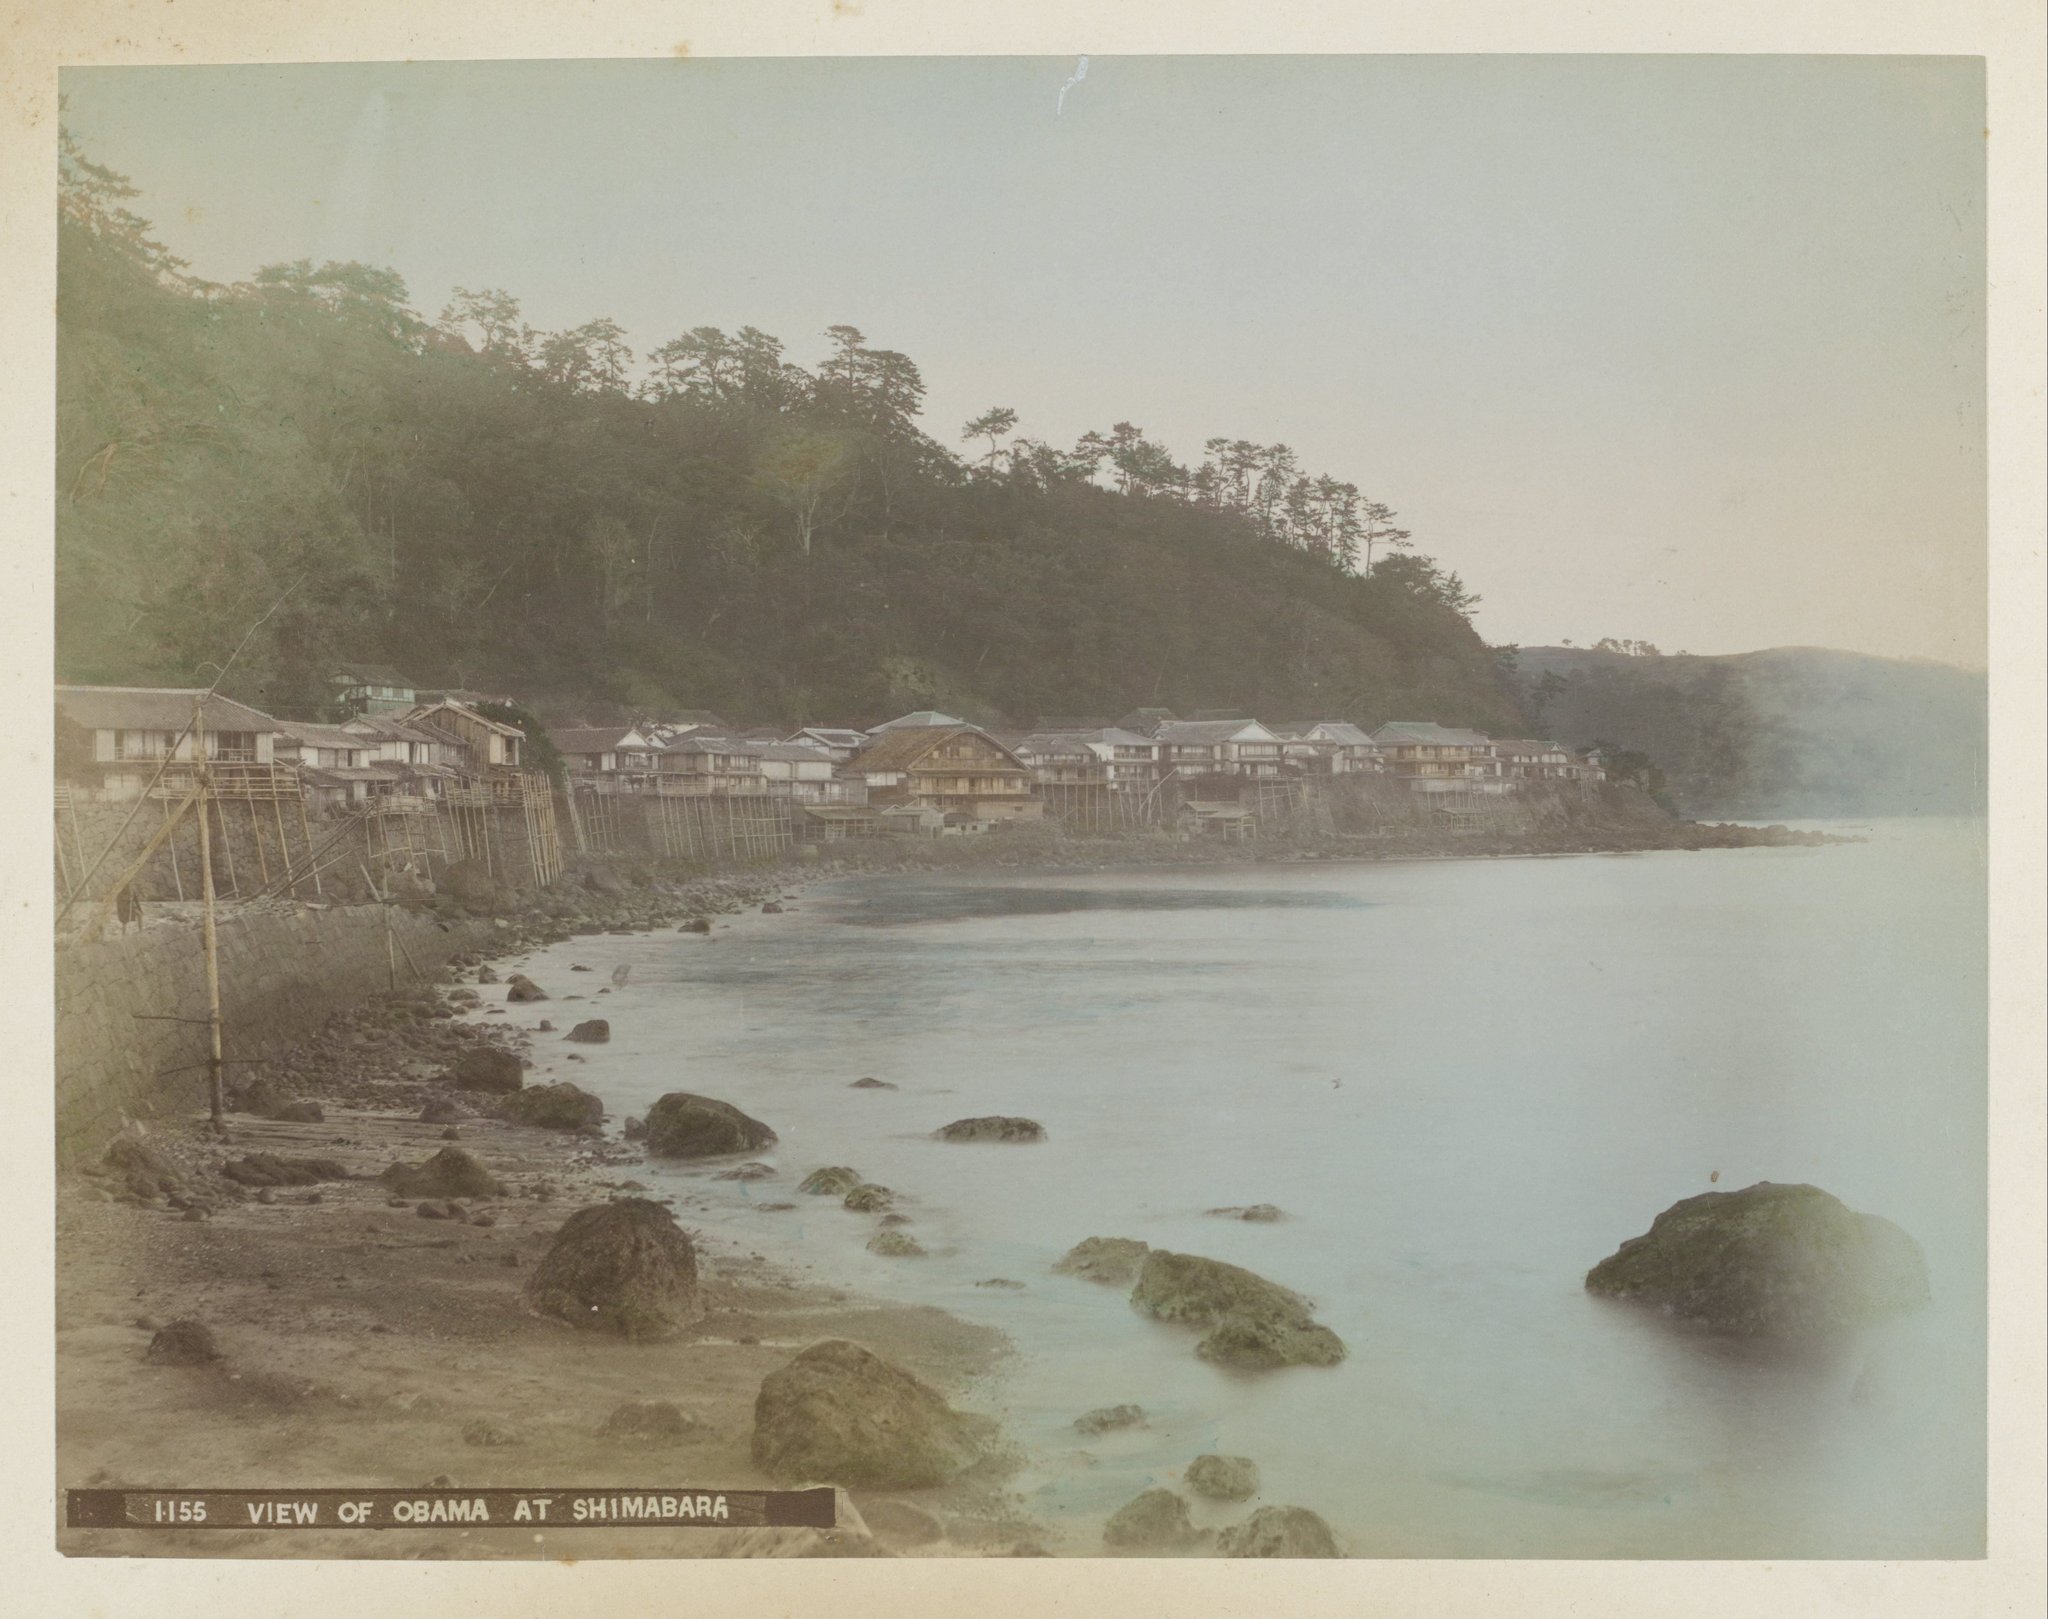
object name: photograph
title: Gezicht op het dorp Obama op Shimabara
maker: Anonymous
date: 1870-1900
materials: paper, photographic support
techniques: albumen print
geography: unzen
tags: prospect of village, silhouette of village, coastal structures (+ landscape with figures, staffage), travelling; tourism, boulder, stone, sea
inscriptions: negative number: ‘1155’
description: Onderdeel van Fotoalbum met 50 foto's van bezienswaardigheden in Japan.